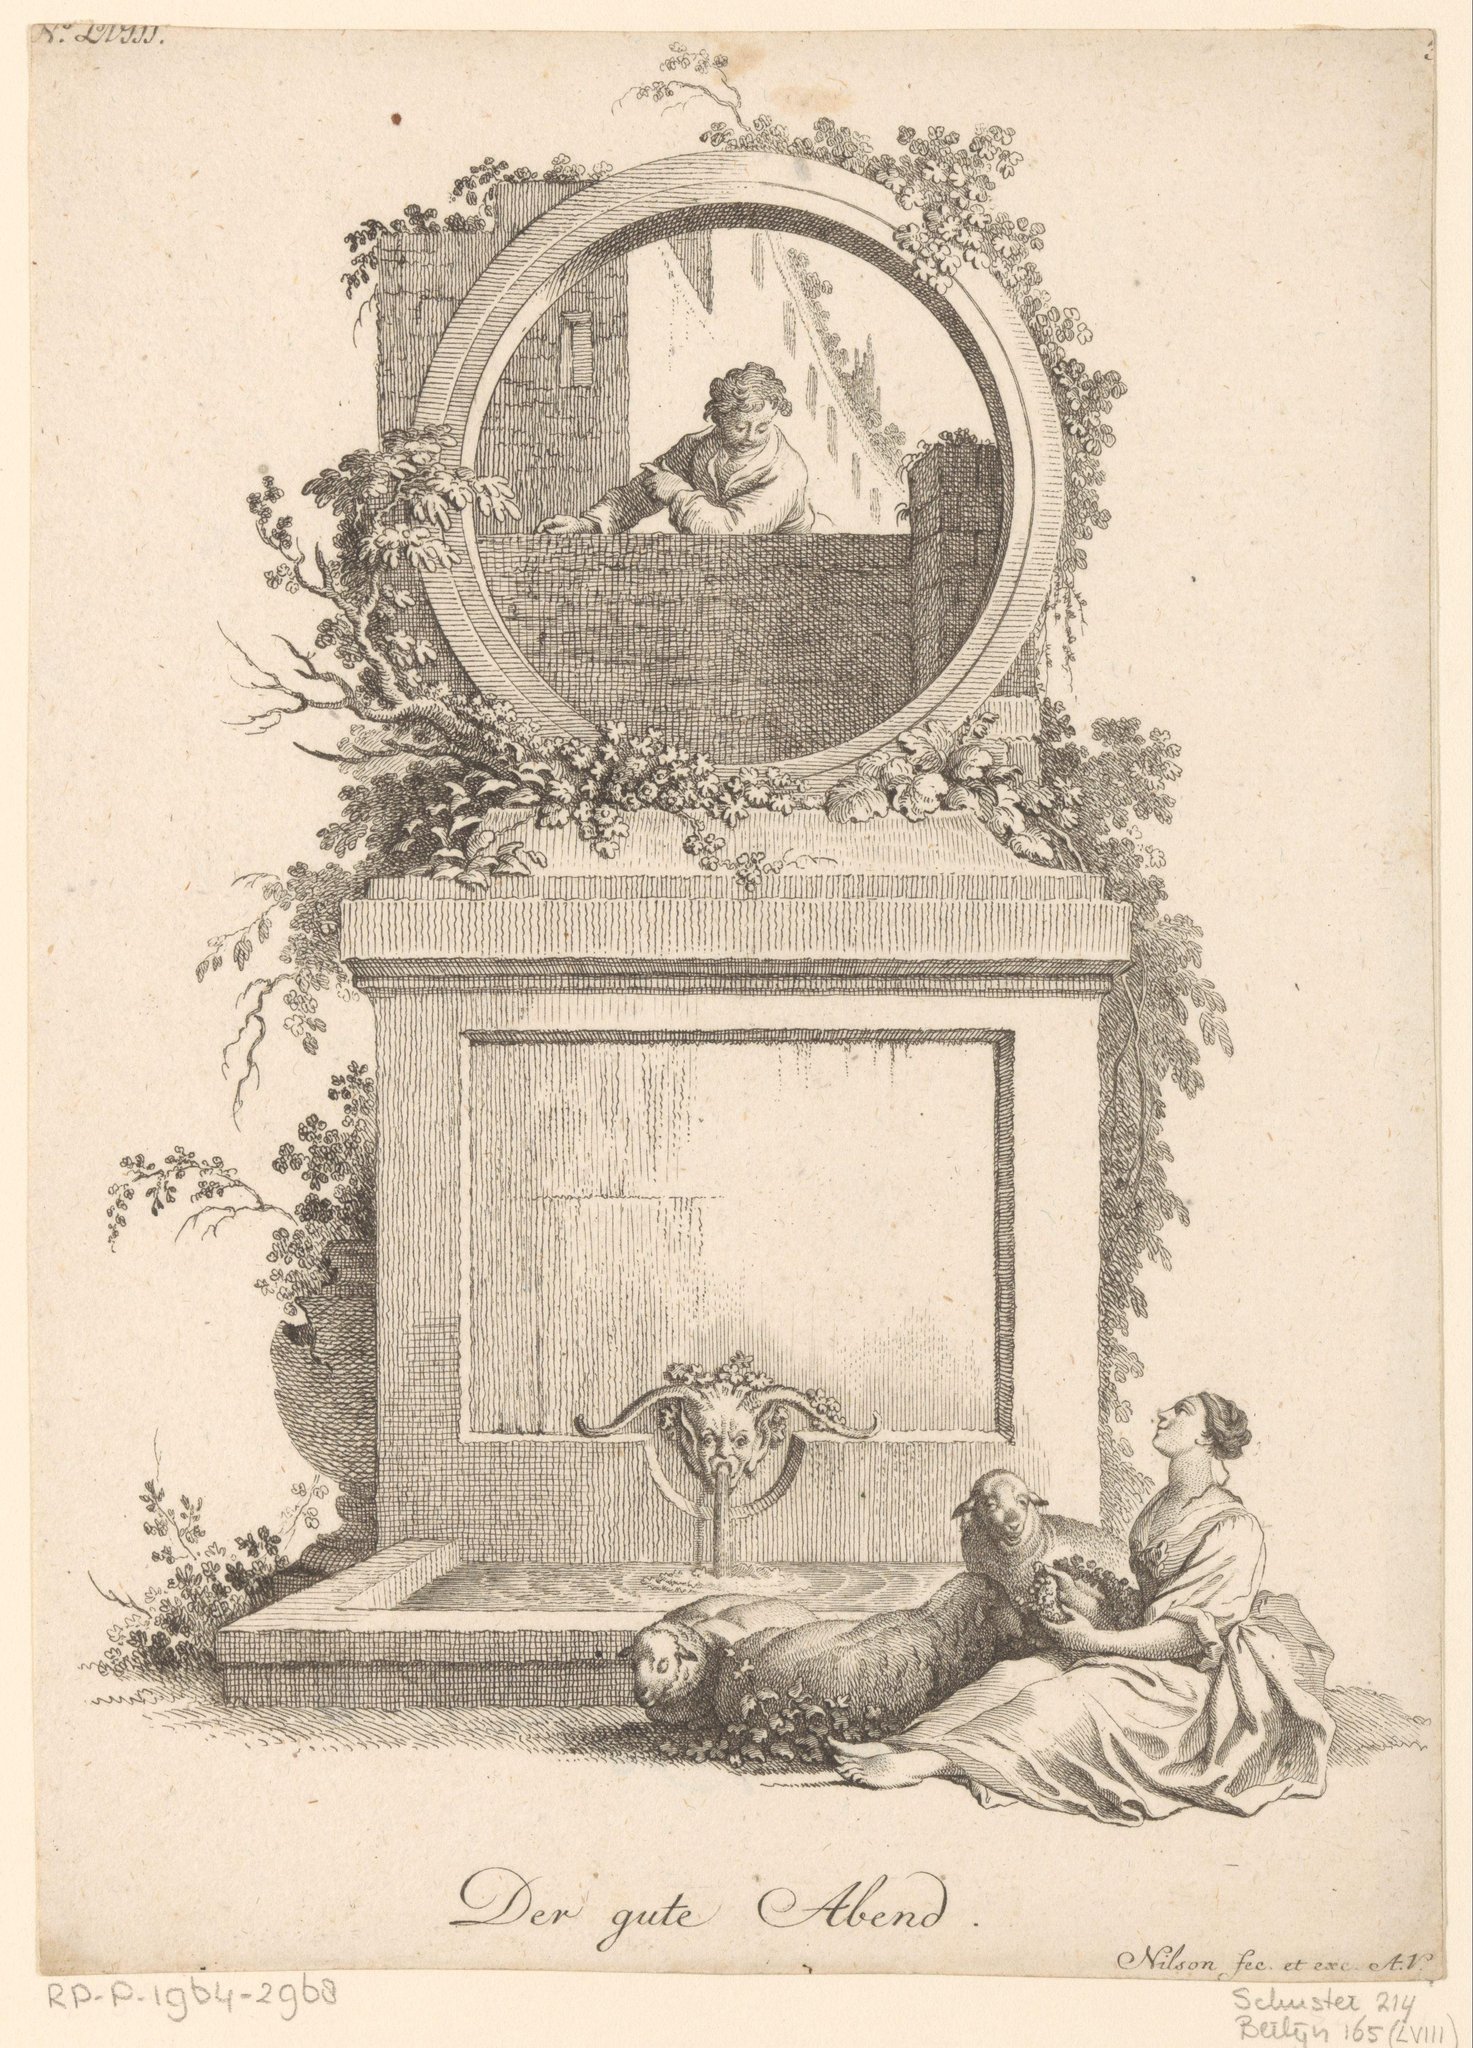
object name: print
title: Dagdelen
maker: johann esaias nilson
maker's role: draughtsman, print maker, publisher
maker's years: 1721-1788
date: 1731-1788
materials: paper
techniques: etching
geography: augsburg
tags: evening, ornamental fountain, pastorals, arcadian scenes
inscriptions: collector's mark: Lugt 2228, collector's mark: Lugt 2760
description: Een herderin met haar kudde schapen zit voor een fontein met een saterkop. Op de fontein rust een ronde doorkijk van waaruit een jongen over een muur naar de herderin kijkt. Uitgeversnummer LVIII.